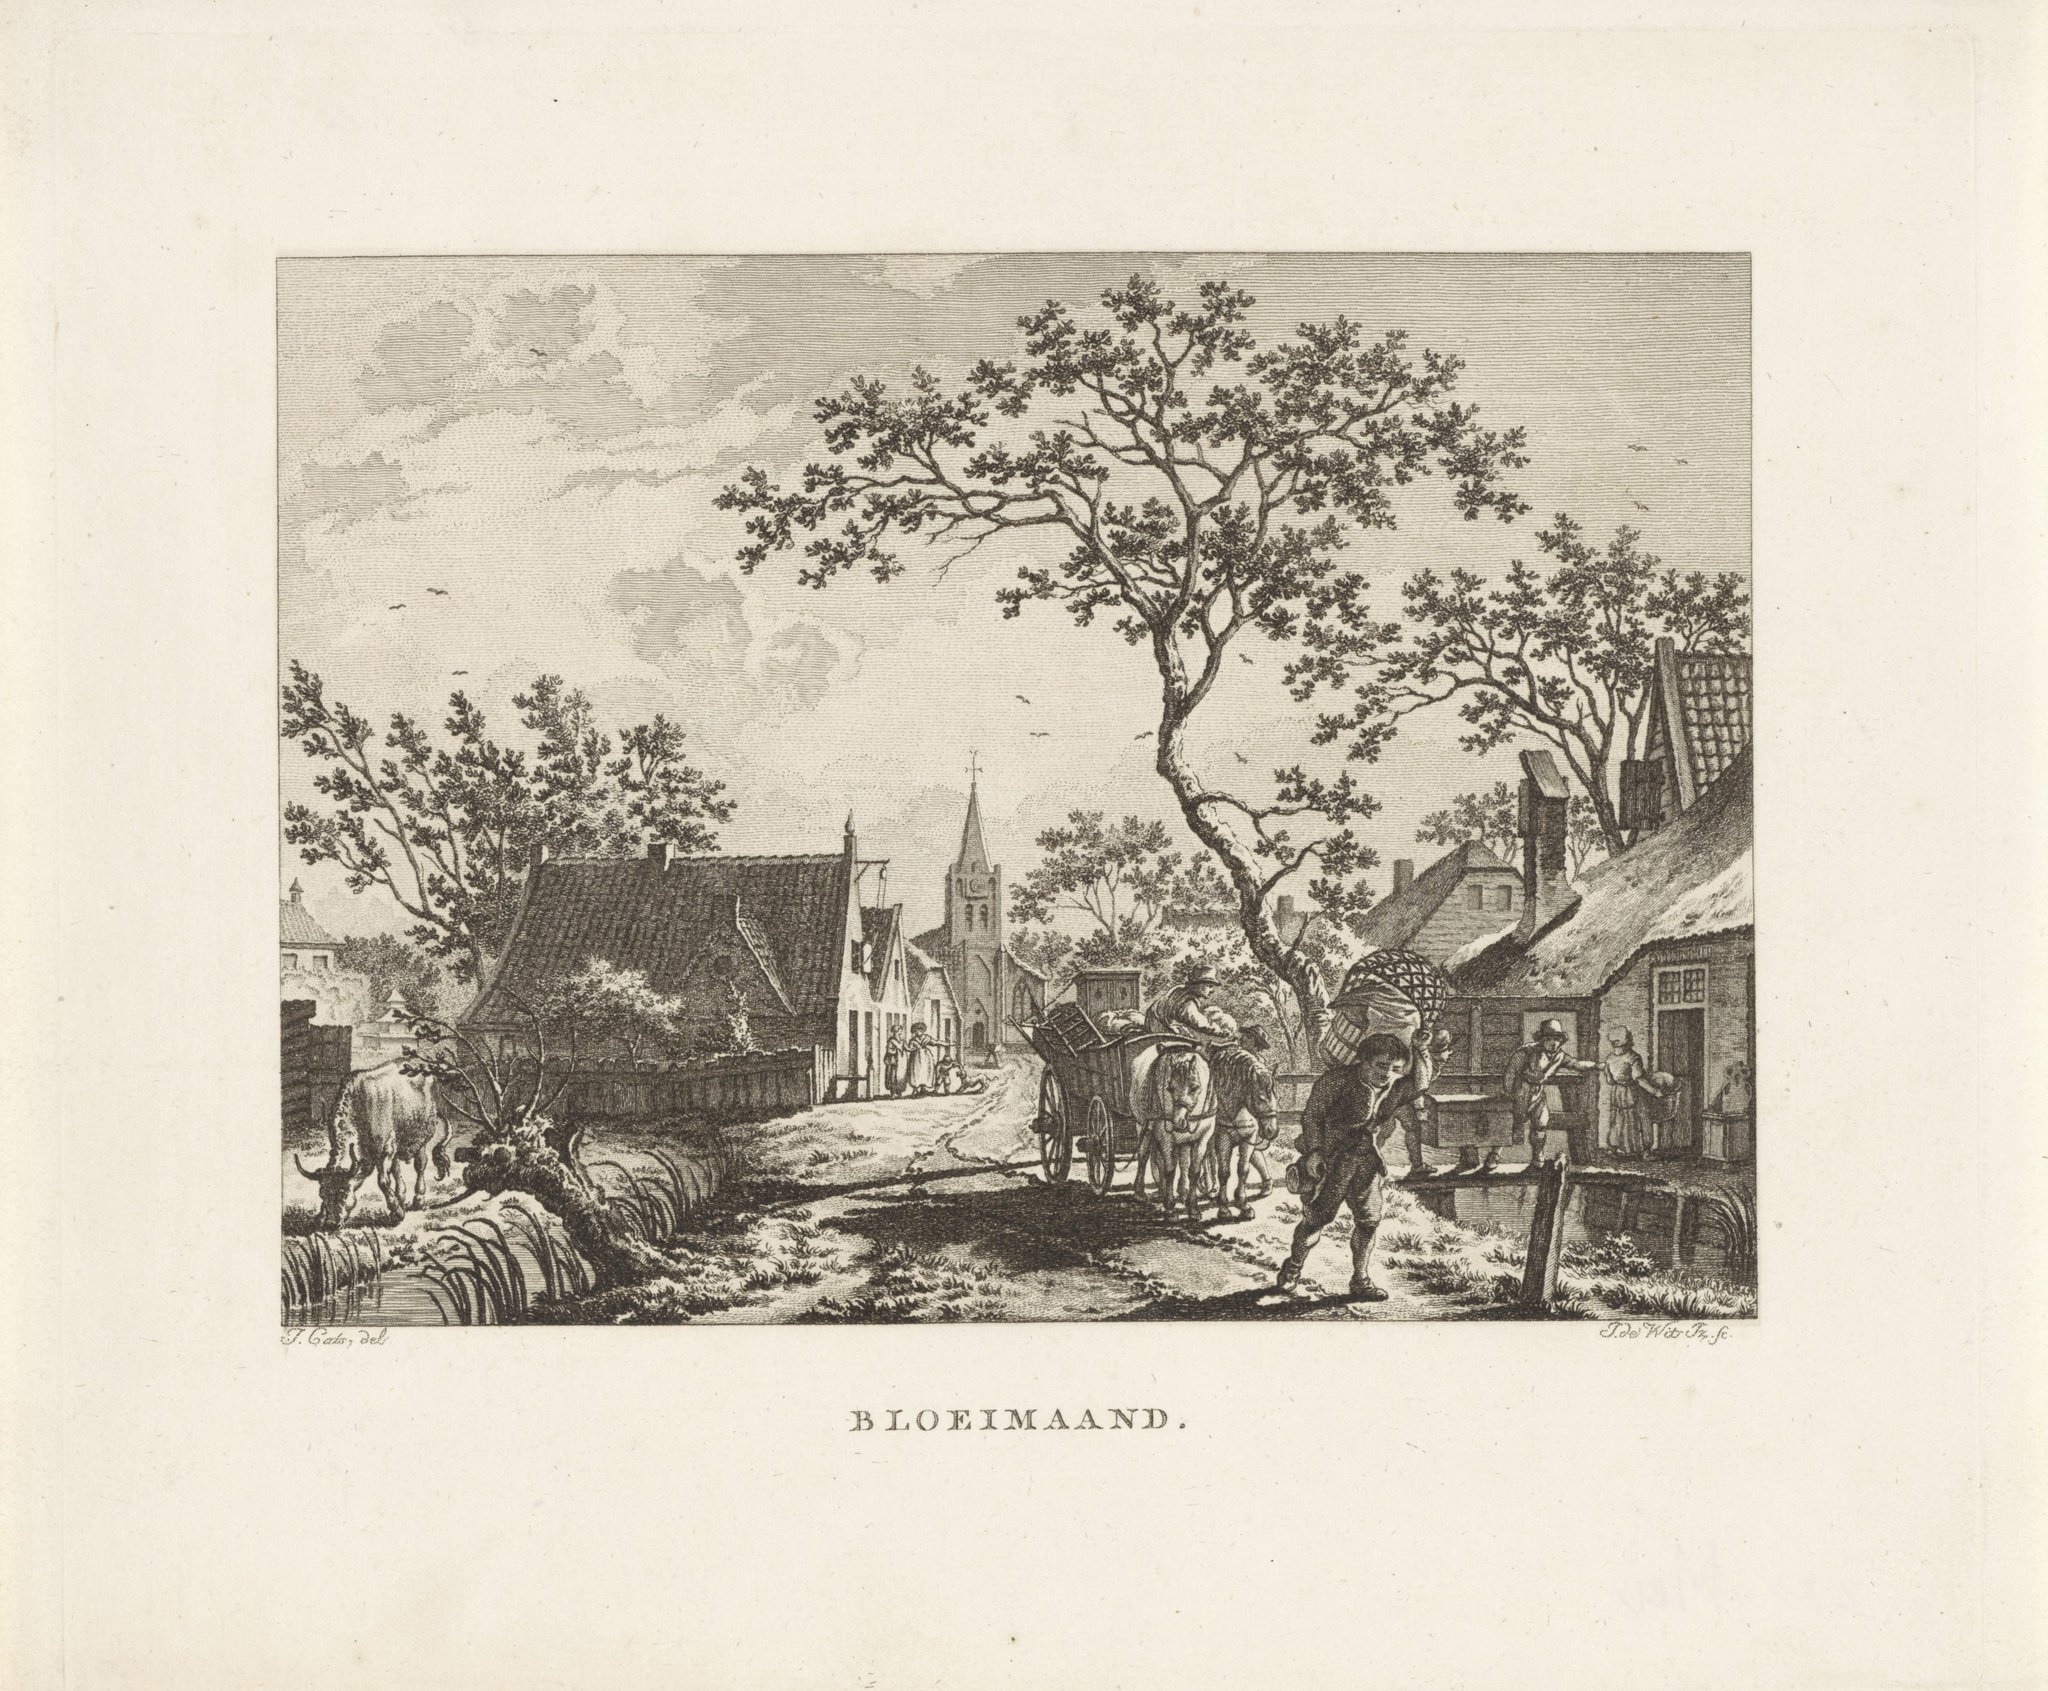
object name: print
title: Bloeimaand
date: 1807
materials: paper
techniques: etching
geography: haarlem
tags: may and its 'labours' (+ with scenes showing human occupations ~ seasons and months), village street, (farm) wagon, freight wagon, cart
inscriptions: signature and date: ‘r.o.: I. de Wit Jz. fc; l.o.: J. Cats del.’, inscription: ‘m.o.: BLOEIMAAND’, collector's mark: Lugt 2228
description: Gezicht in een dorp met een verhuizing. De meubels en kisten worden van een kar met twee paarden ervoor geladen en een huis binnengedragen. Op de voorgrond een man met mand op de rug.